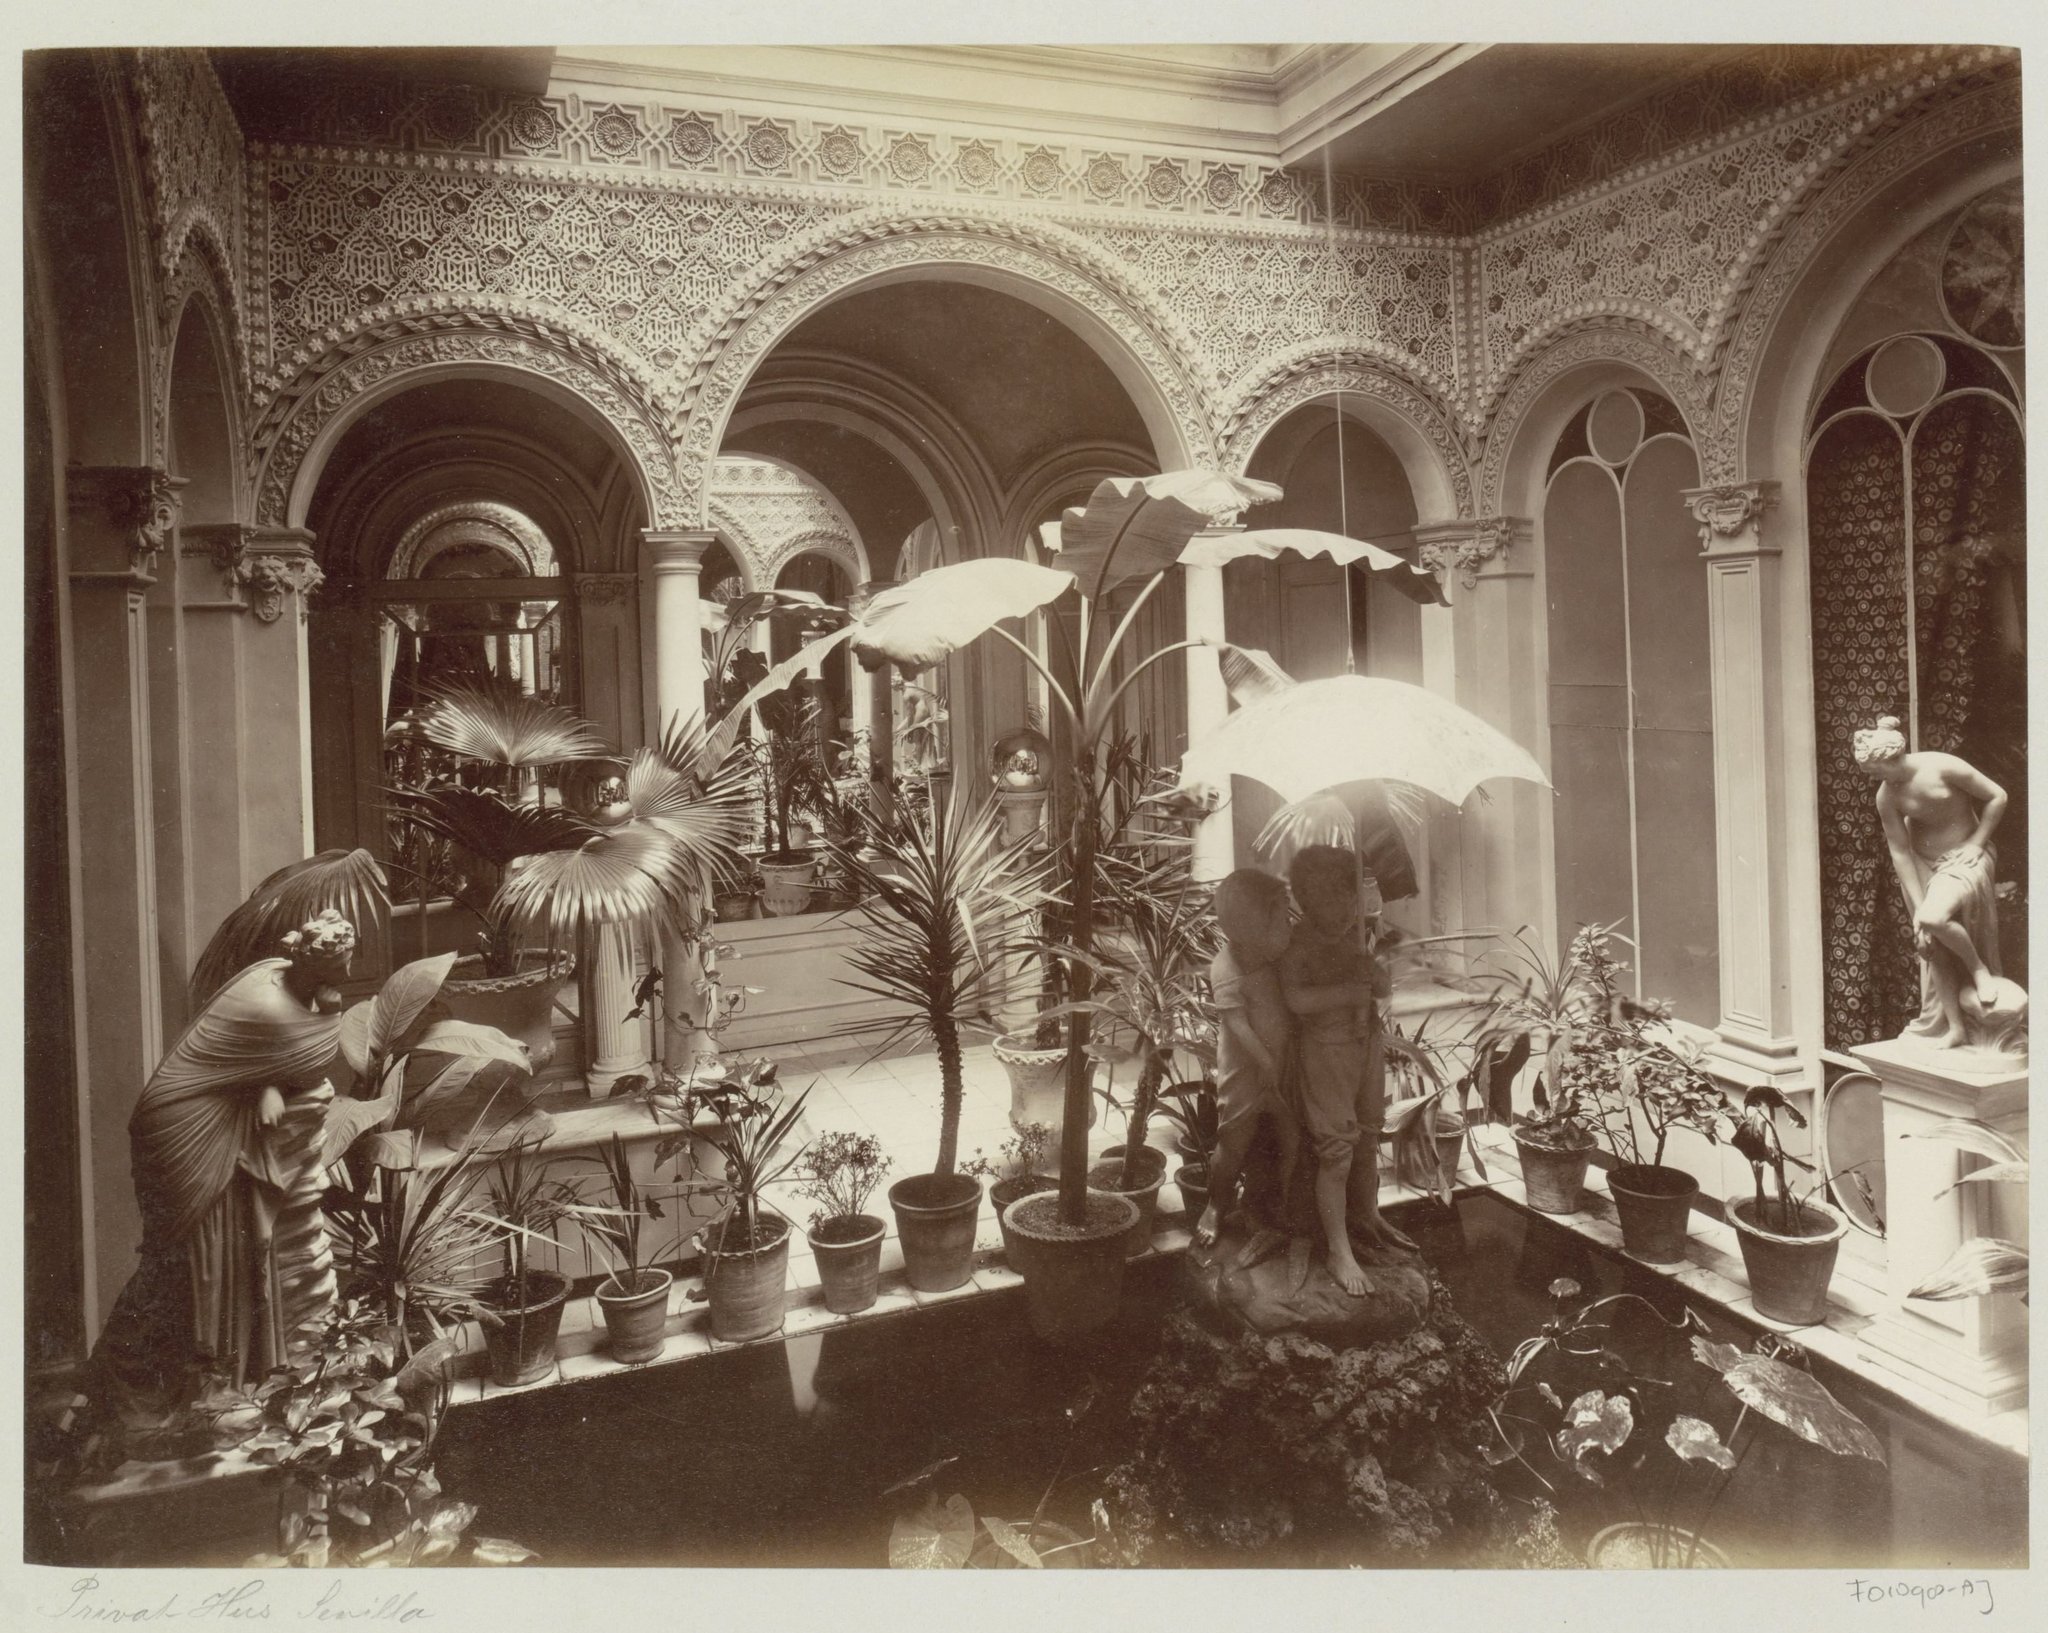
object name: photograph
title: Binnenhof van een huis in Sevilla met arcaden, beelden en planten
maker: Anonymous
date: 1860-1880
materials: cardboard, paper, photographic support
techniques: albumen print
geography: sevilla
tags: interior of the house, courtyard, sevilla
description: Onderdeel van Reisalbum met foto's van bezienswaardigheden in Spanje en Marokko.